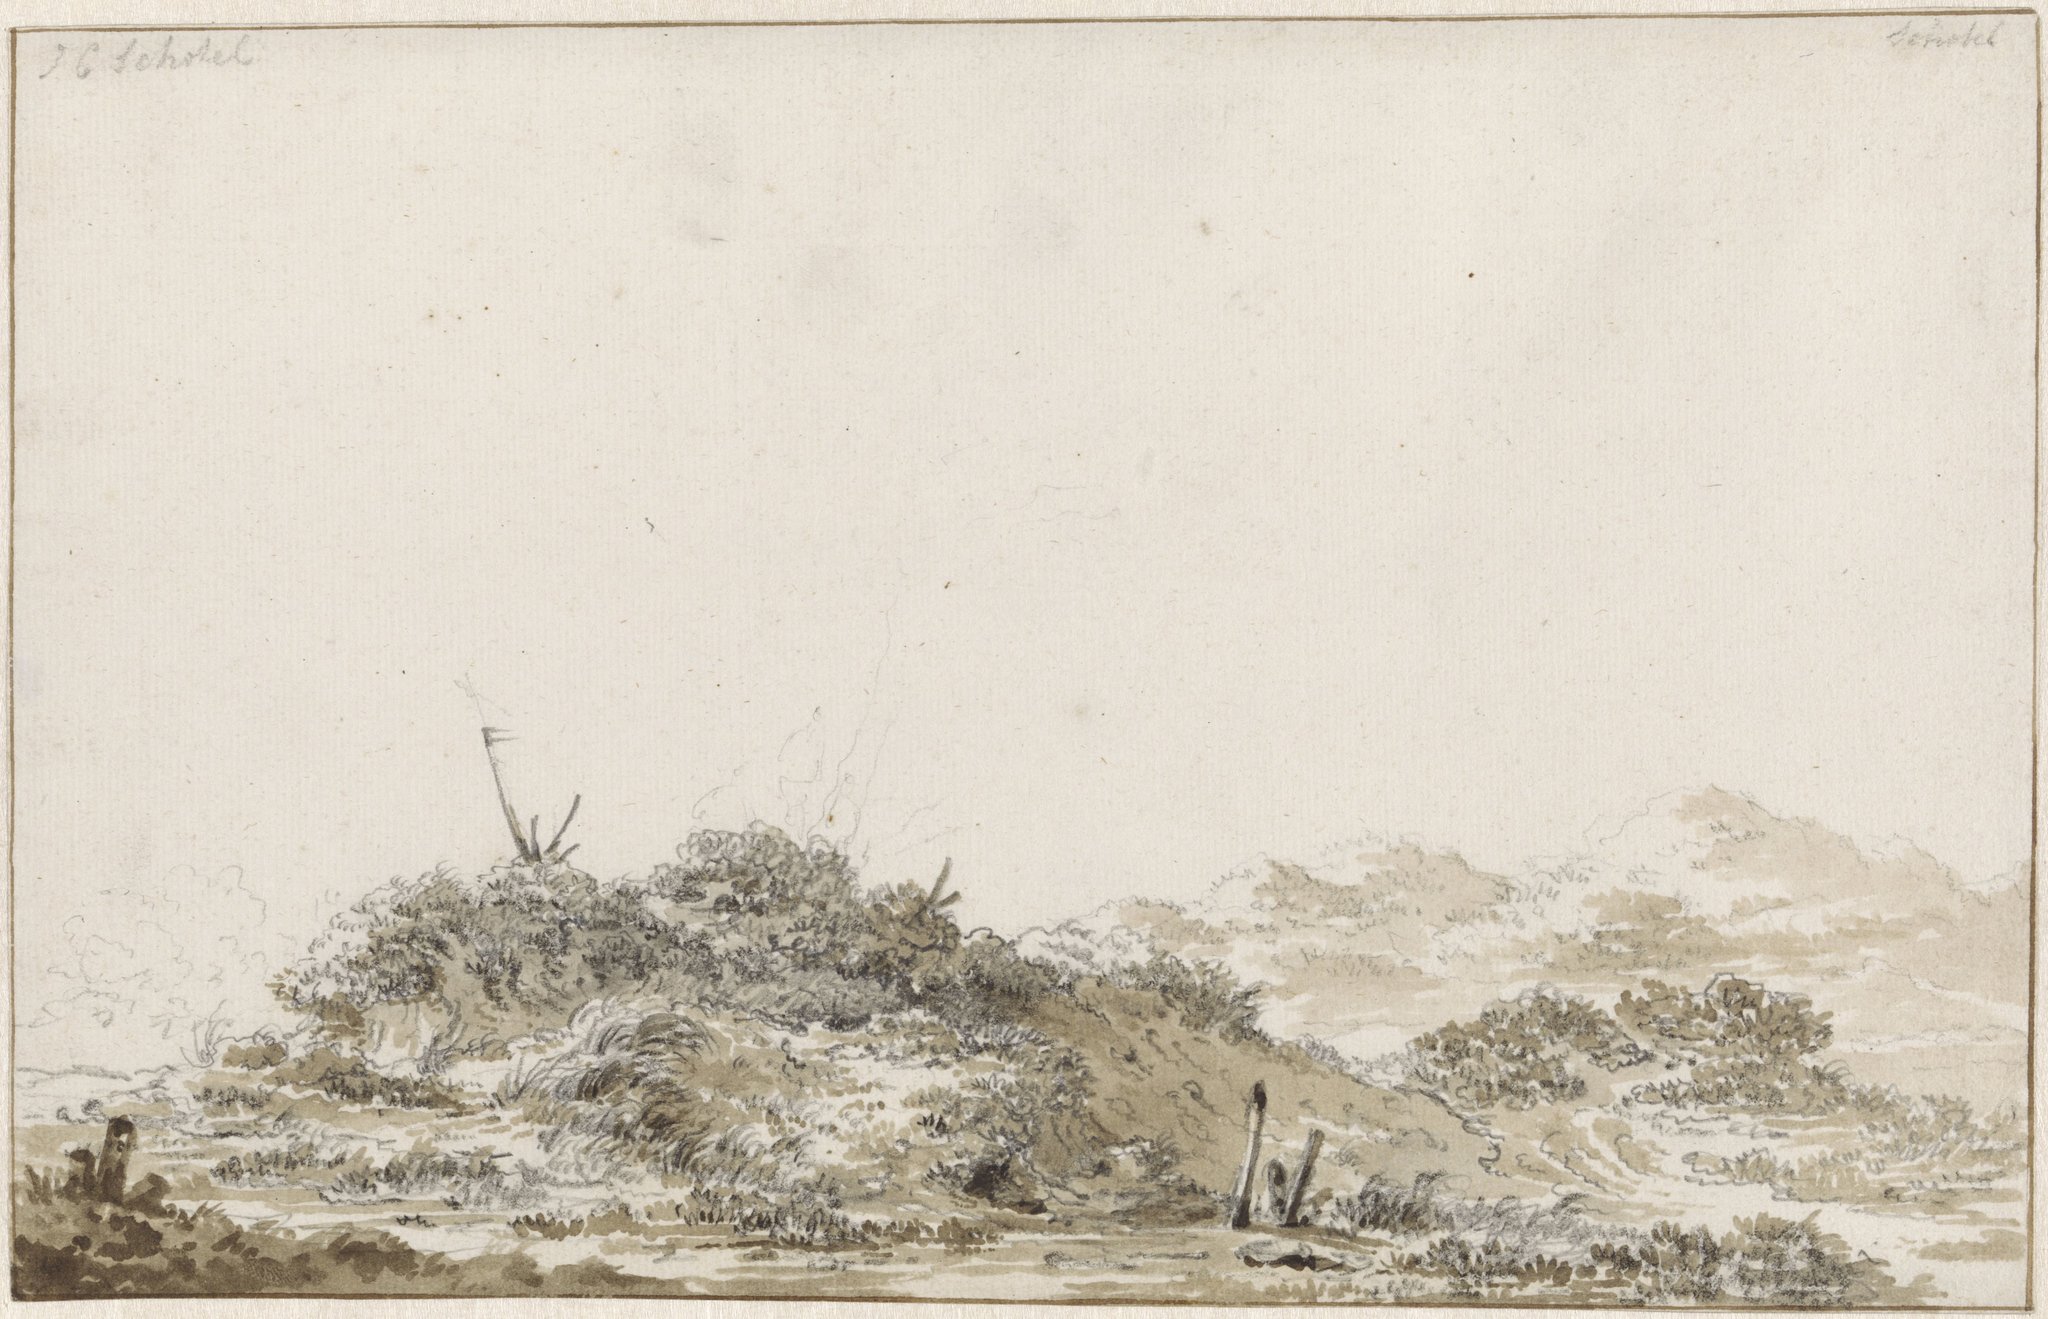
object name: drawing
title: Duinlandschap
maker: johannes christiaan schotel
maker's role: draughtsman, painter, print maker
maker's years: 1787-1838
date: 1797-1838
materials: chalk, paper, pencil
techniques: brush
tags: dunes (sea not visible); in the dunes